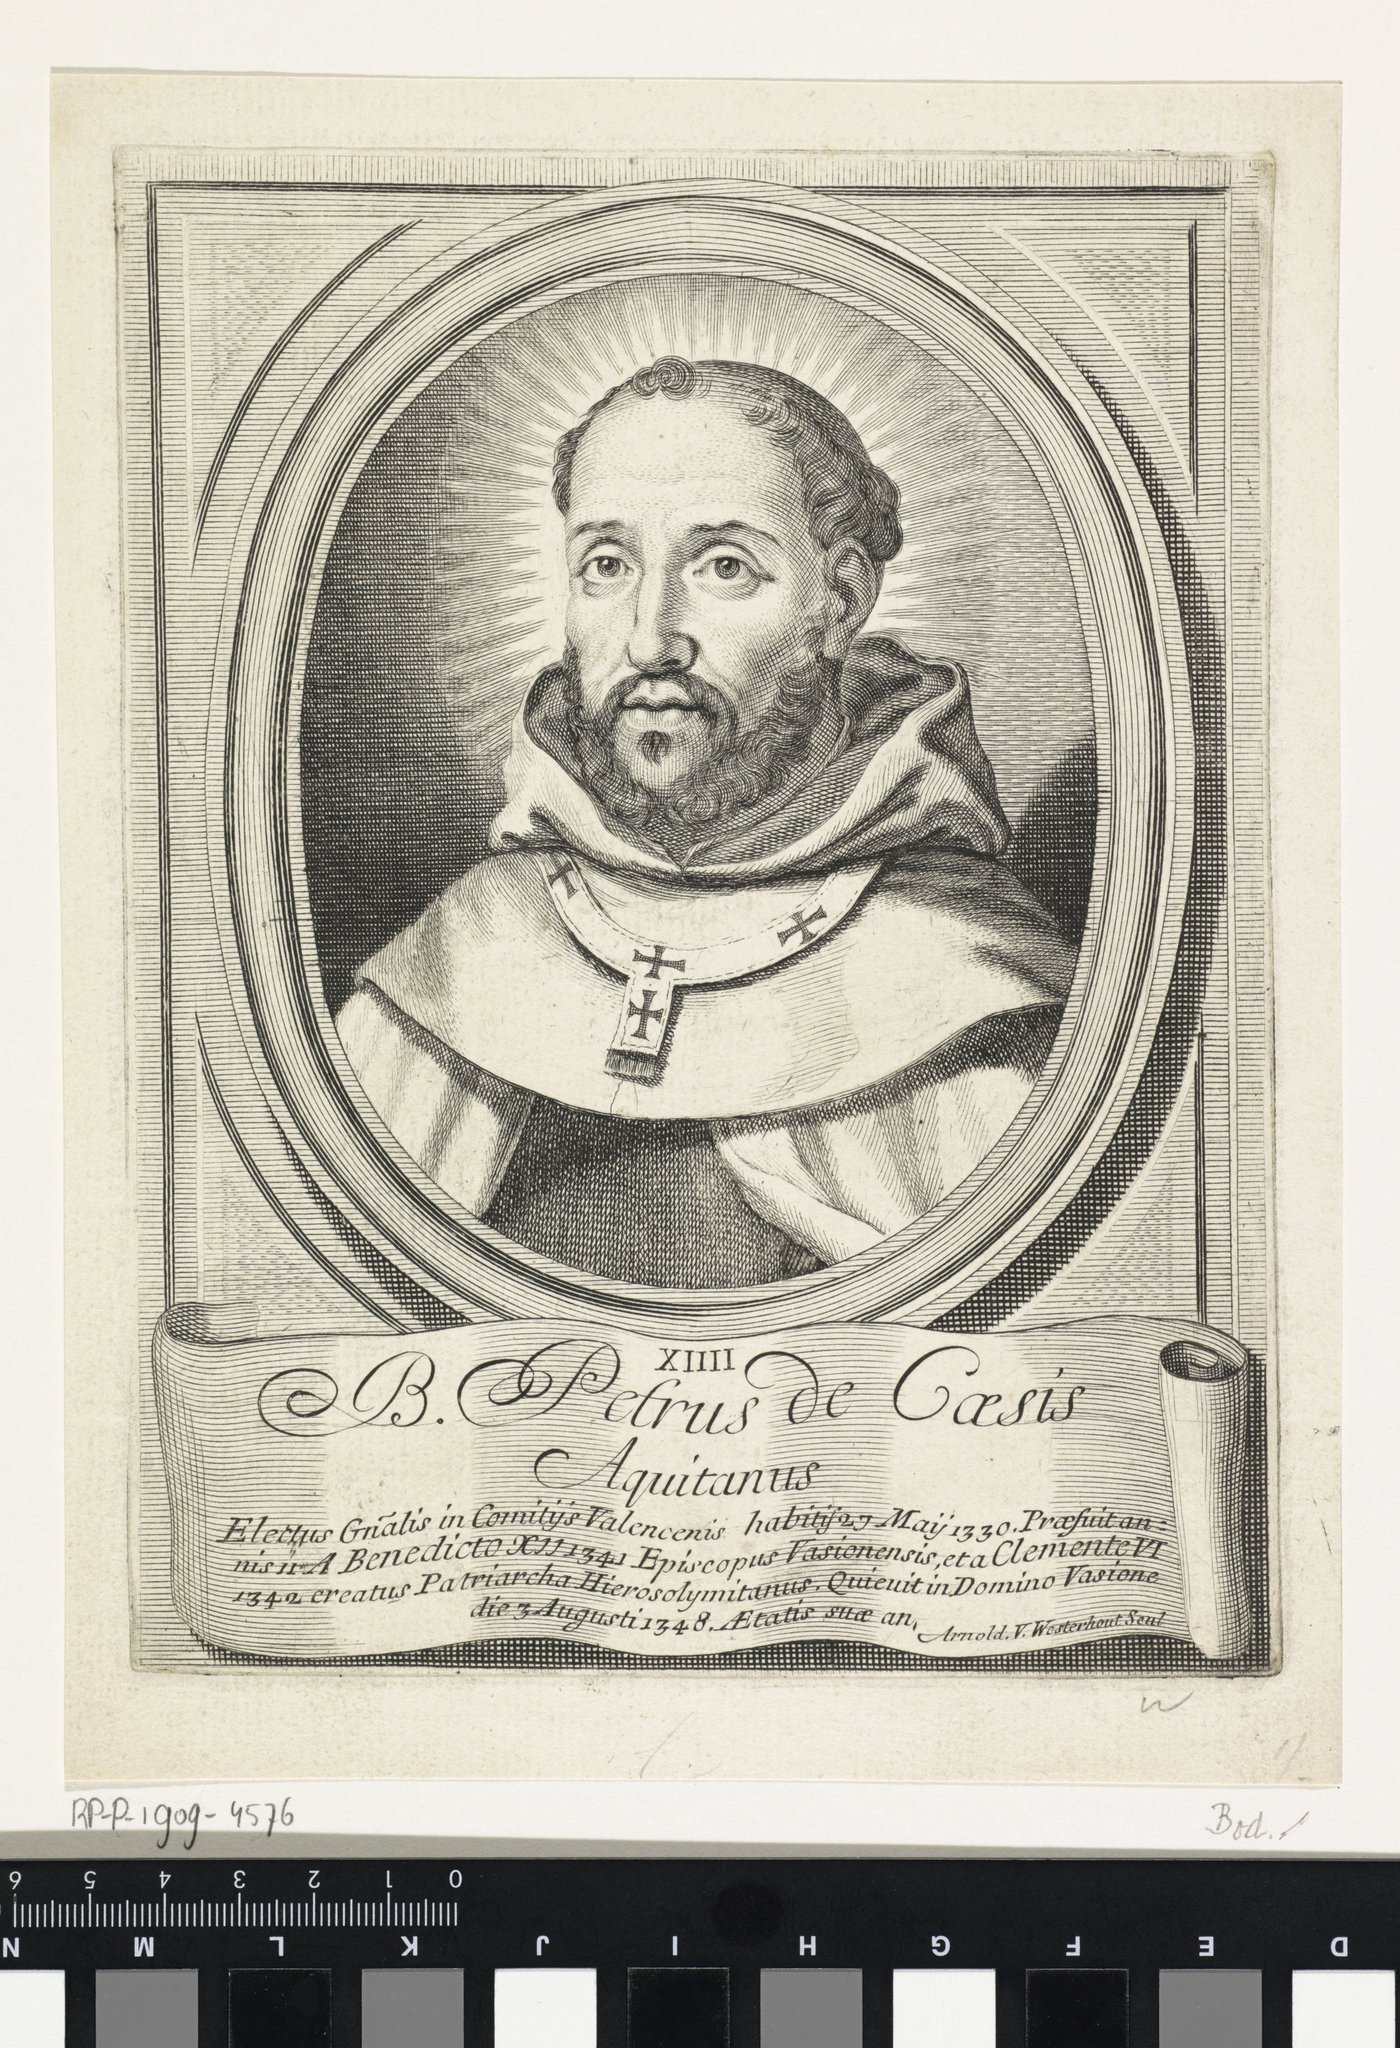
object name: print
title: Portret van Petrus de Casis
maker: arnold van westerhout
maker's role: print maker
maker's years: 1651-1725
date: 1665-1725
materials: paper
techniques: engraving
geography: italy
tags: petrus de casis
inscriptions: collector's mark: Lugt 2228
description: Prent gebruikt in: Ventimiglia, Mariano. Historia chronologica priorum Generalium Latinorum Ordinis Beatissimae Virginis Mariae de Monte Carmelo. Napels: Simoniana, 1773.